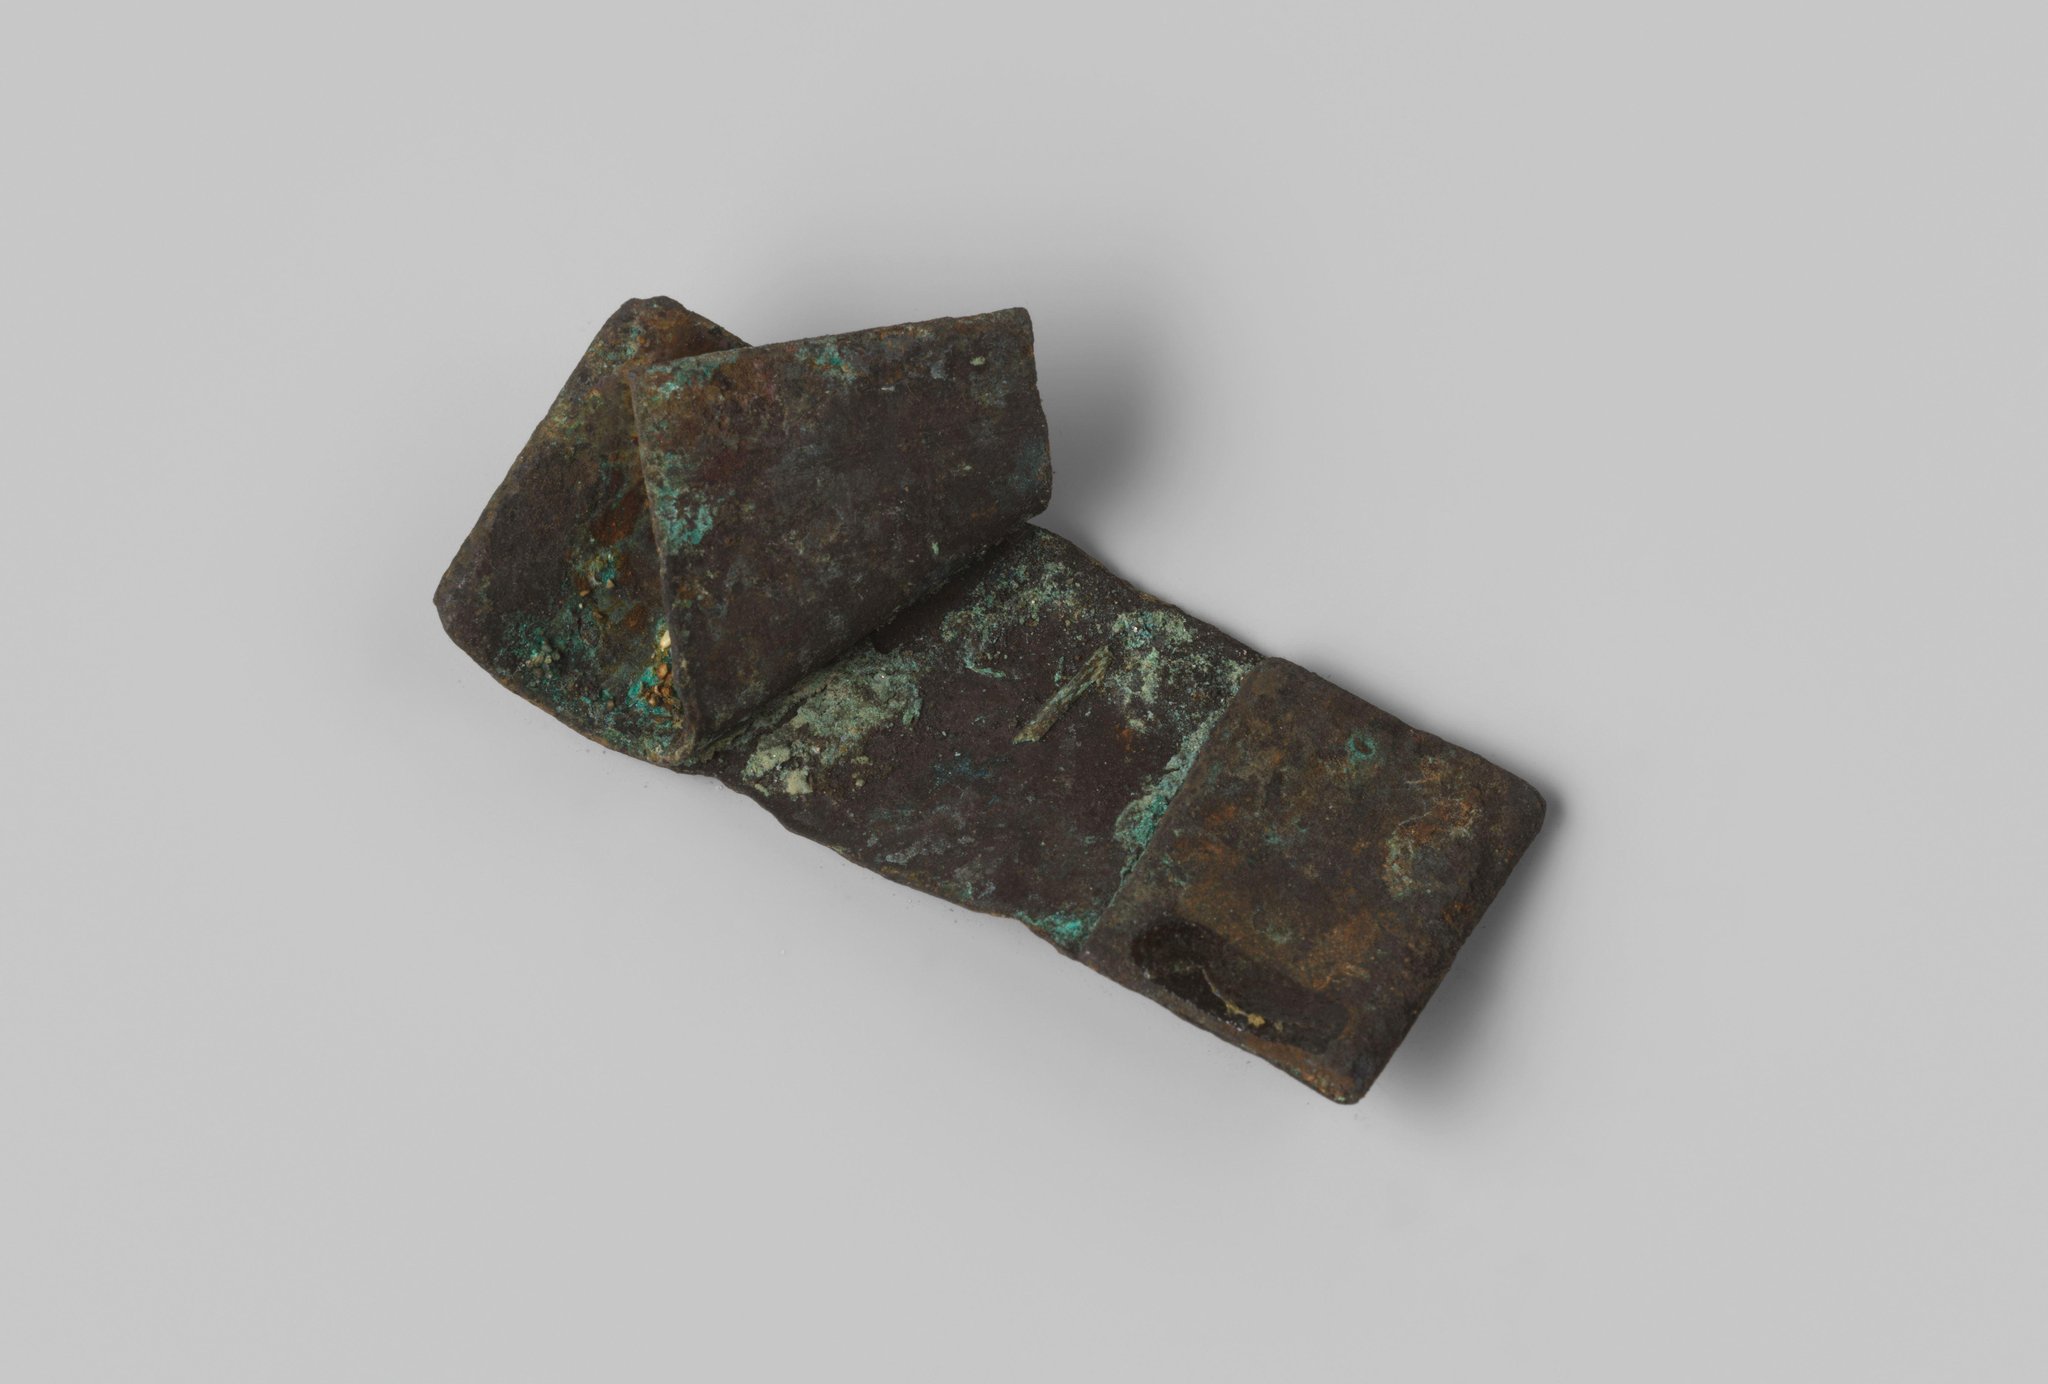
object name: firehose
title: Fragment van een brandslangring uit het wrak van de Oost-Indiëvaarder Hollandia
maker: Anonymous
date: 1700-1743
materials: copper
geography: netherlands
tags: verenigde oostindische compagnie, hollandia (schip), annet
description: Fire engine, firehose; fragment, id. NG-1975-20-H-1271-a, squashed.